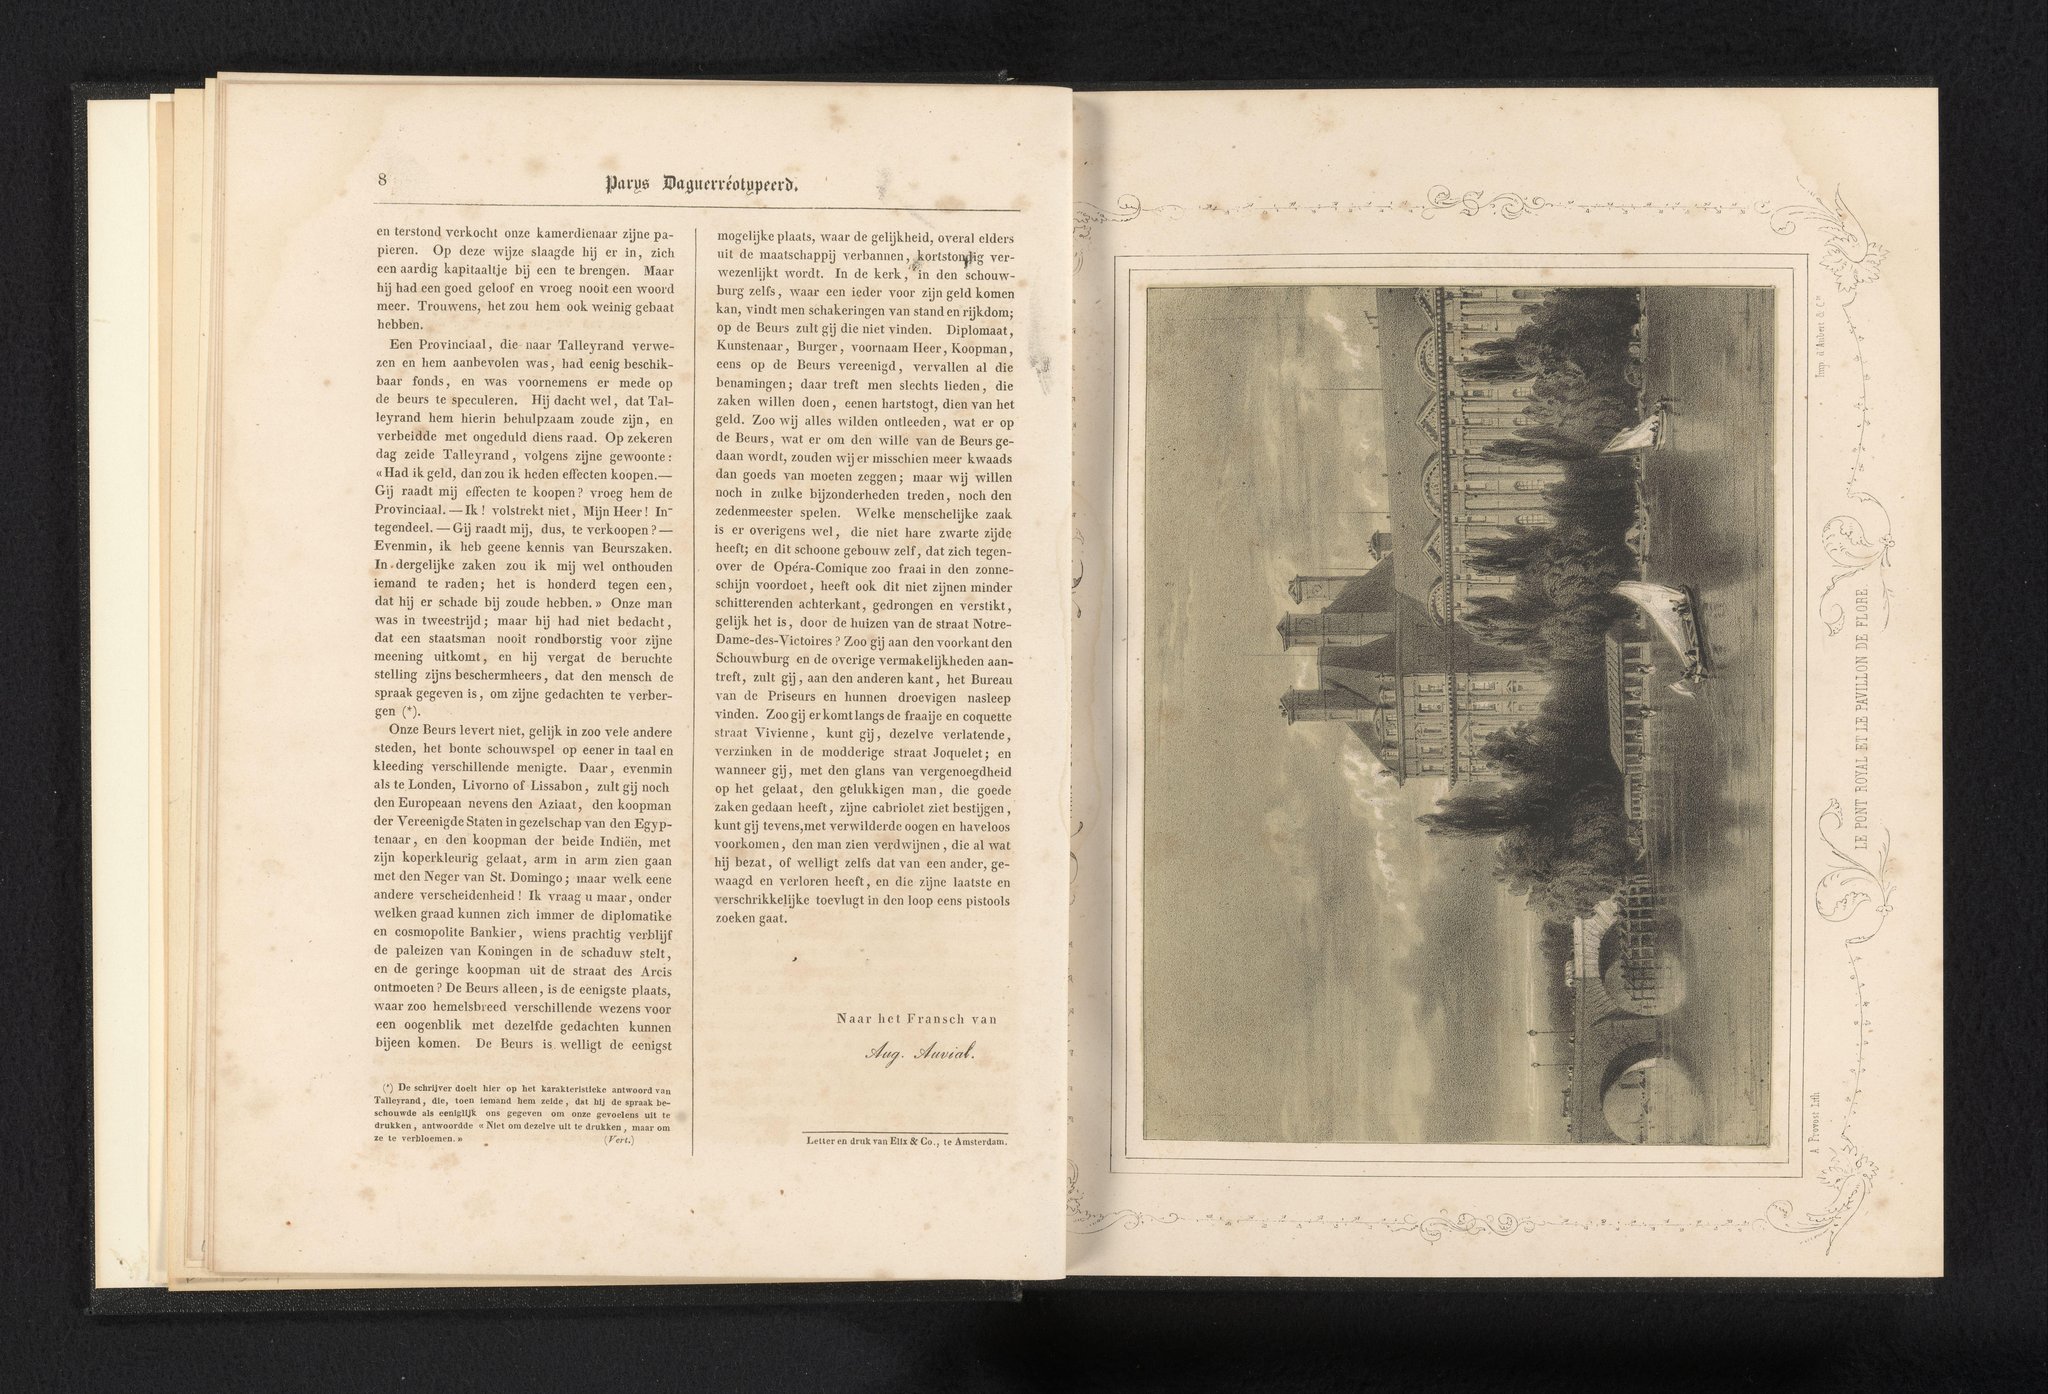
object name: page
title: Pont Royal bij het Pavillon de Flore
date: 1839-1840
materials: paper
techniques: tone lithography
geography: paris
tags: palace, bridge in city across river, canal, etc.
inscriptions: inscription: ‘PARIS DAGUERRÉOTYPÉ No. 3.’